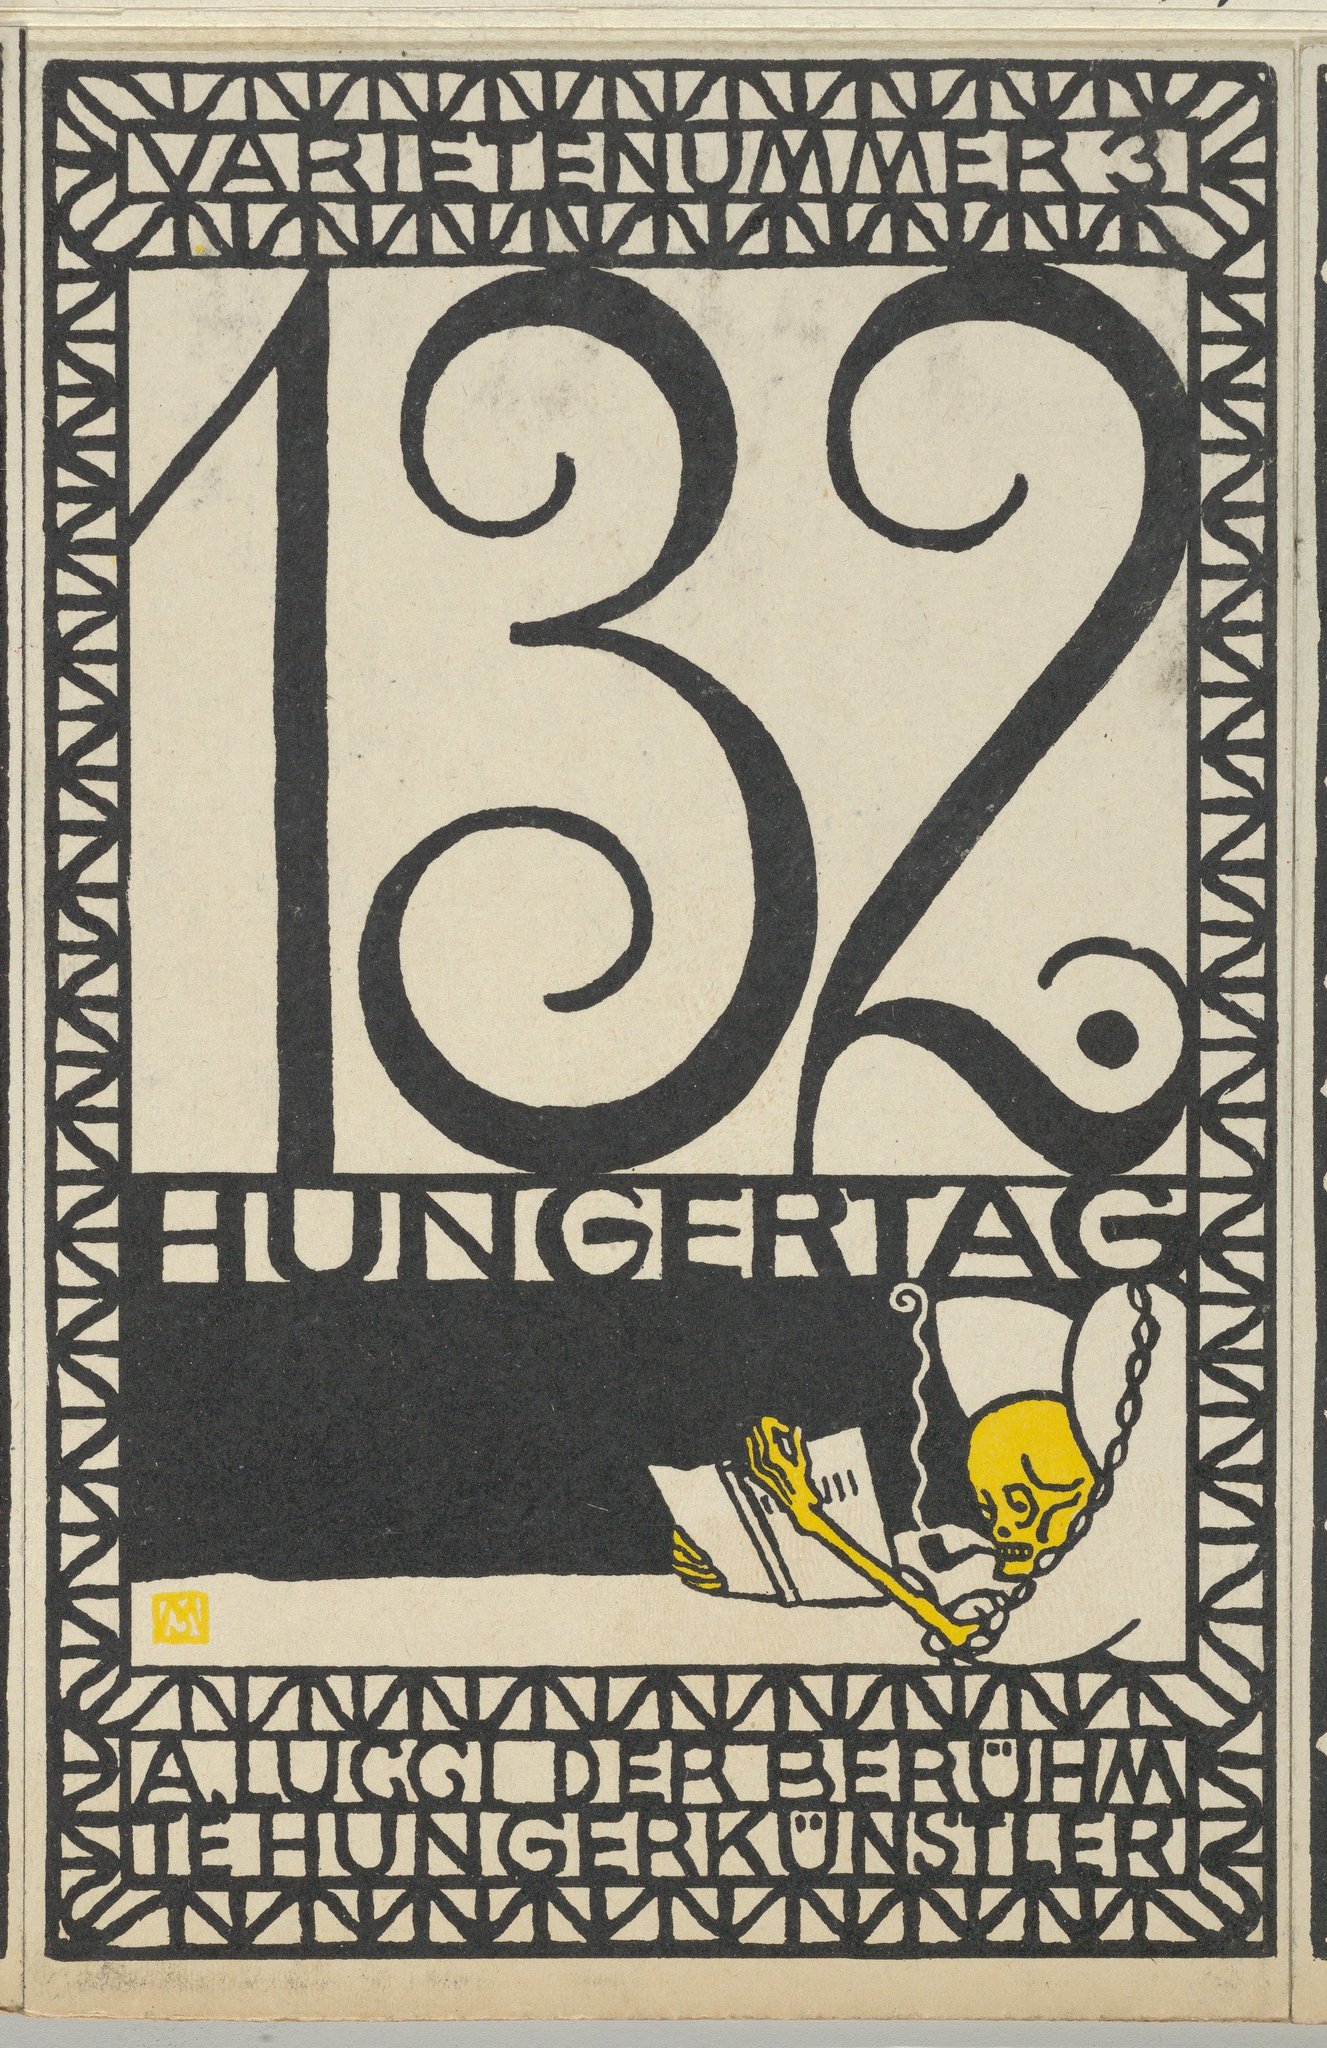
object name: print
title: Variety Act 3: 132nd Day of Fasting, A. Lucci the Famous Hunger Artist (Varietenummer 3: 132 Hungertag, A. Lucci der Berühmte Hungerkünstler)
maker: moriz jung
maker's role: artist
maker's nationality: austrian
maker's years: 1885-1915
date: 1907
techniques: lithograph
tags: skulls,reading,smoking